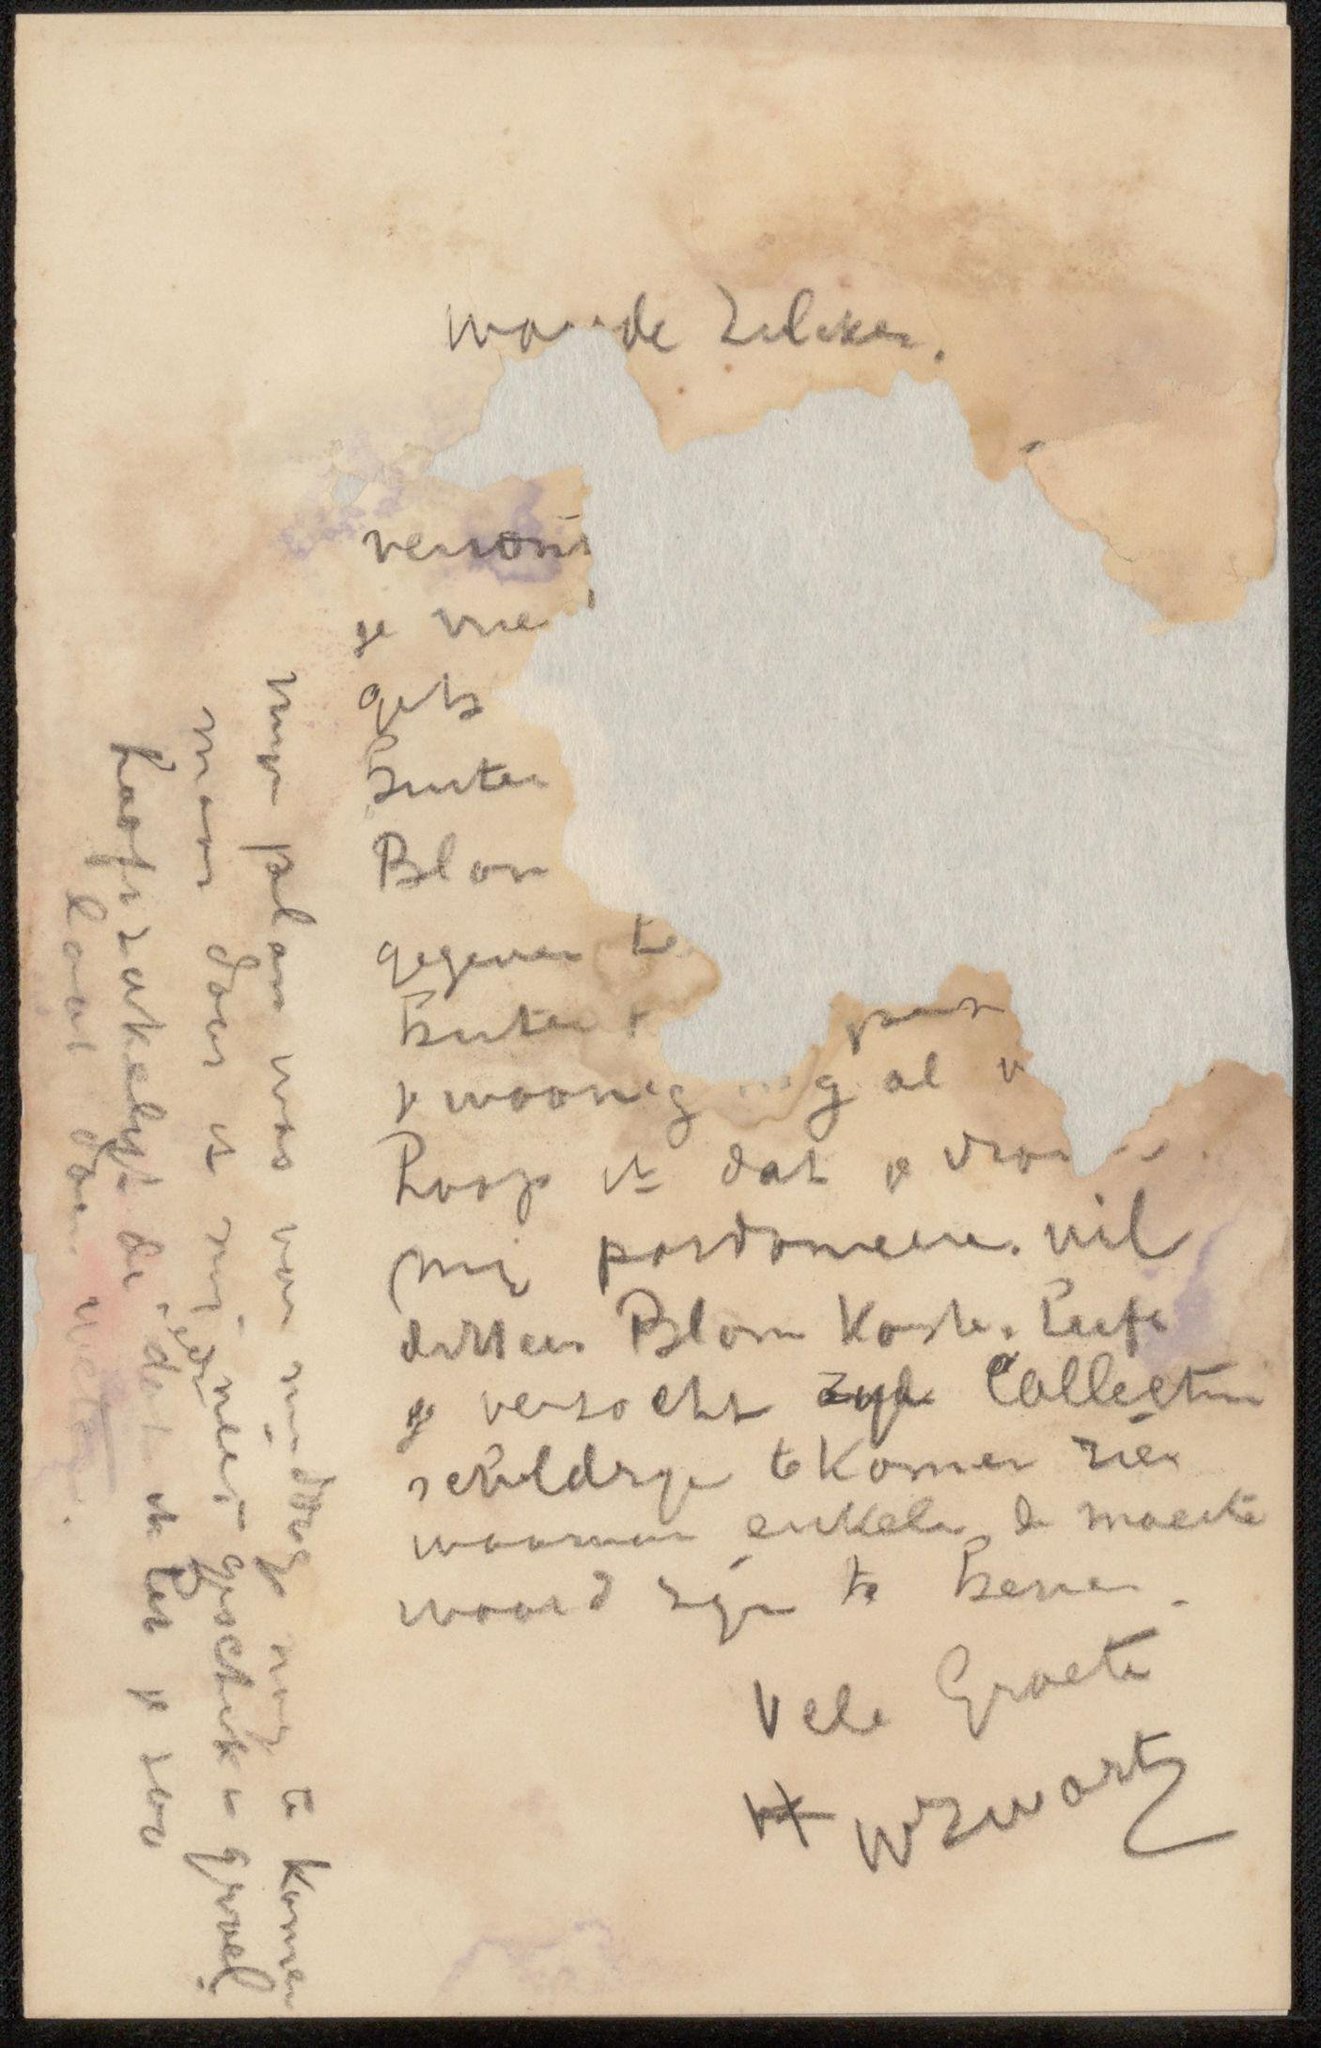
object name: letter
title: Brief aan Philip Zilcken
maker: willem de zwart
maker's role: draughtsman, painter, print maker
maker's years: 1862-1931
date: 1872-1904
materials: paper, pencil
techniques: writing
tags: painter, draughtsman, philip zilcken, painting (including book-illumination, miniature-painting), art collecting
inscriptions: collector's mark: ‘RPK’